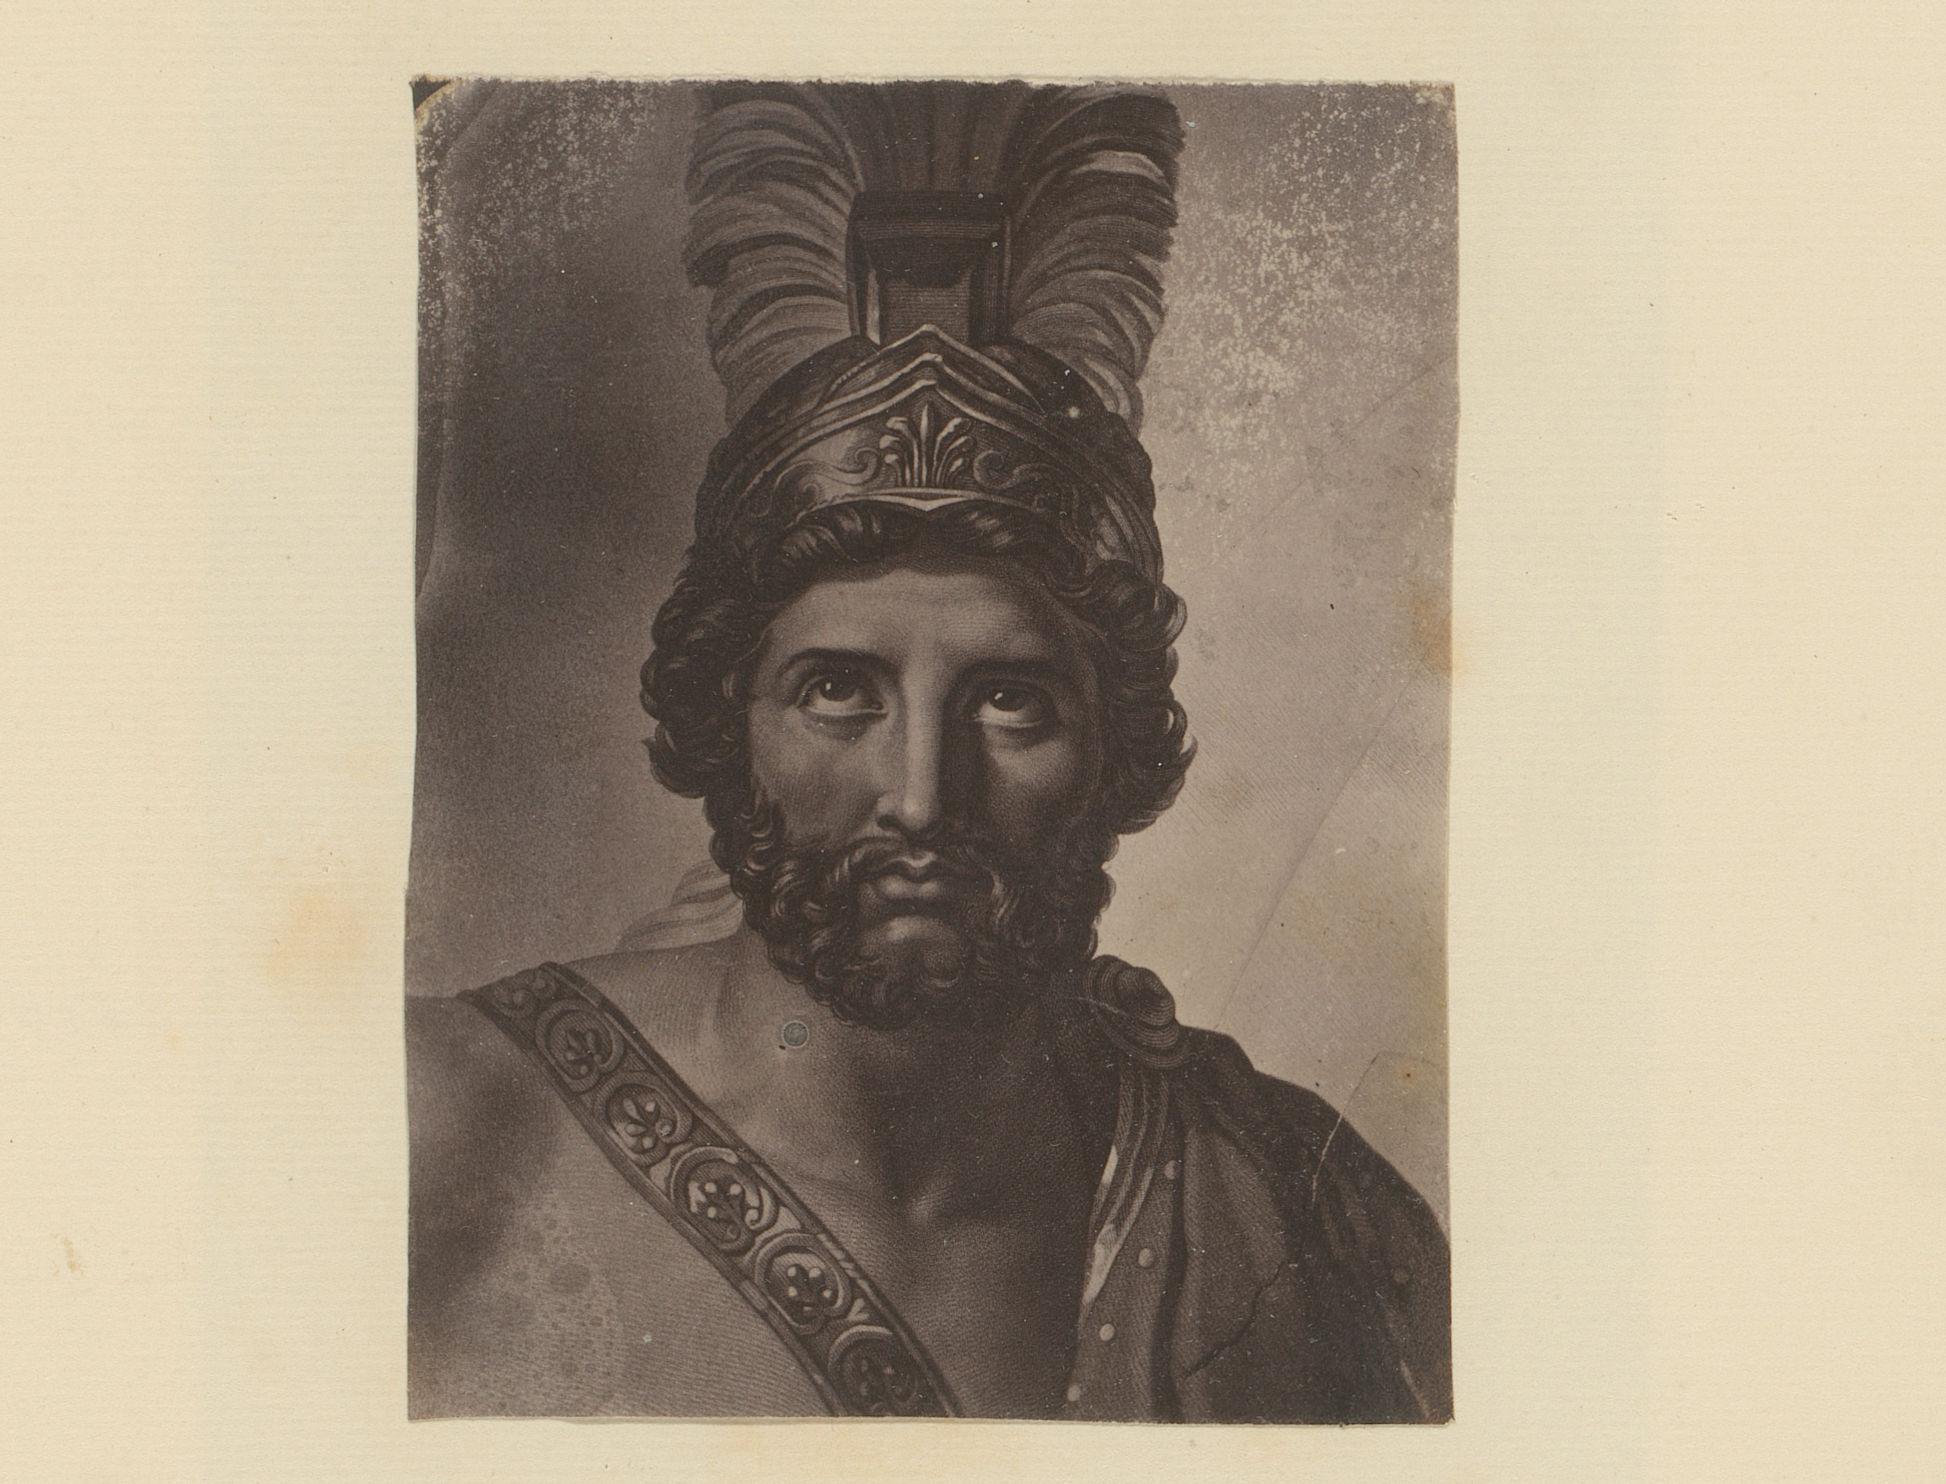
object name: photograph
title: Portret schilderij van Leonidas, koning van Sparta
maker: eduard isaac asser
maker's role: amateurfotograaf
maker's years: 1809-1894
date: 1855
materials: cardboard, paper, photographic support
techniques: salted paper print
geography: amsterdam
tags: male persons from classical history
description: Foto-reproductie van een prent naar een fragment van het schilderij Léonidas aux Thermopyles van Jacques-Louis David